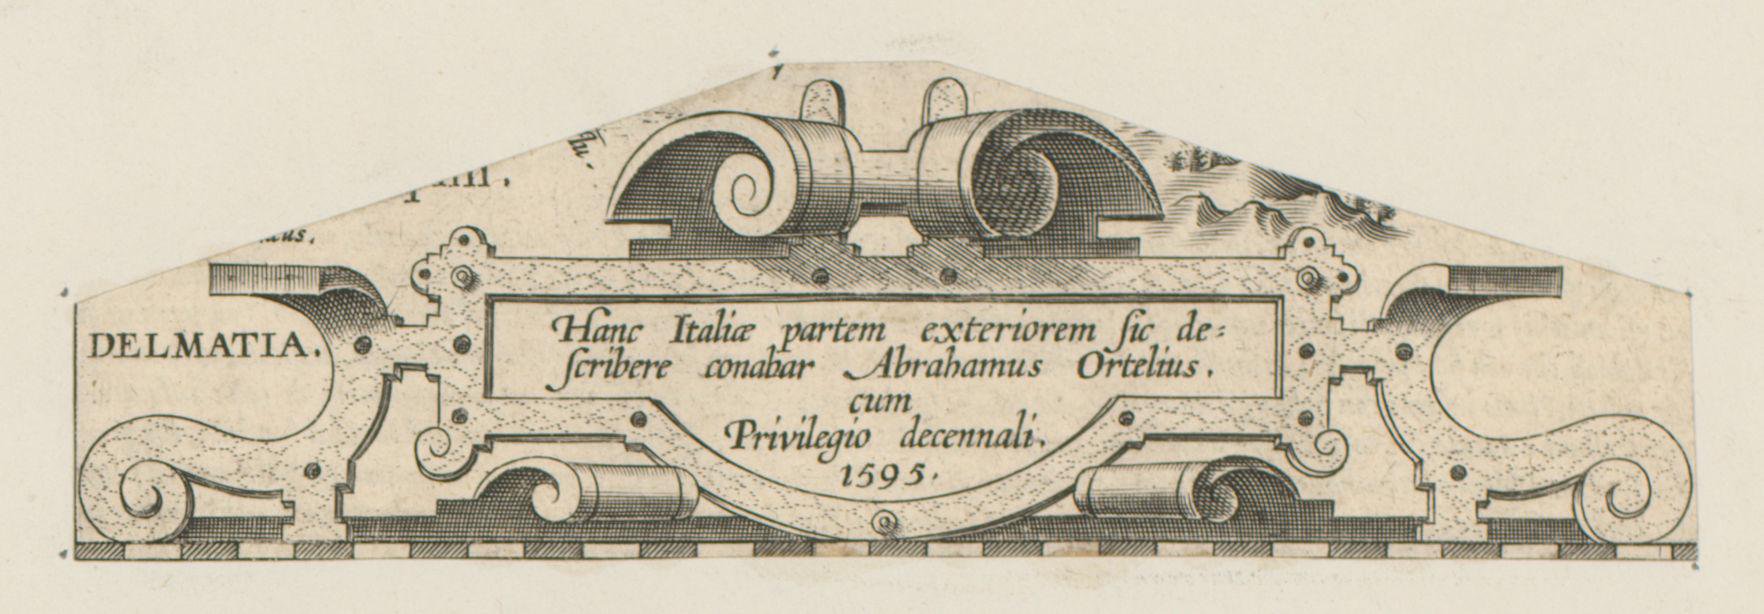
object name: print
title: Itala nam tellus Graecia Major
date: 1595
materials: paper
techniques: engraving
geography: antwerp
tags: scrollwork, strapwork ~ ornament, ornament ~ cartouche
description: Cartouche met rol- en beslagwerk. De cartouche is een fragment van een kaart van Zuid-Italië. De prent maakt deel uit van een album.